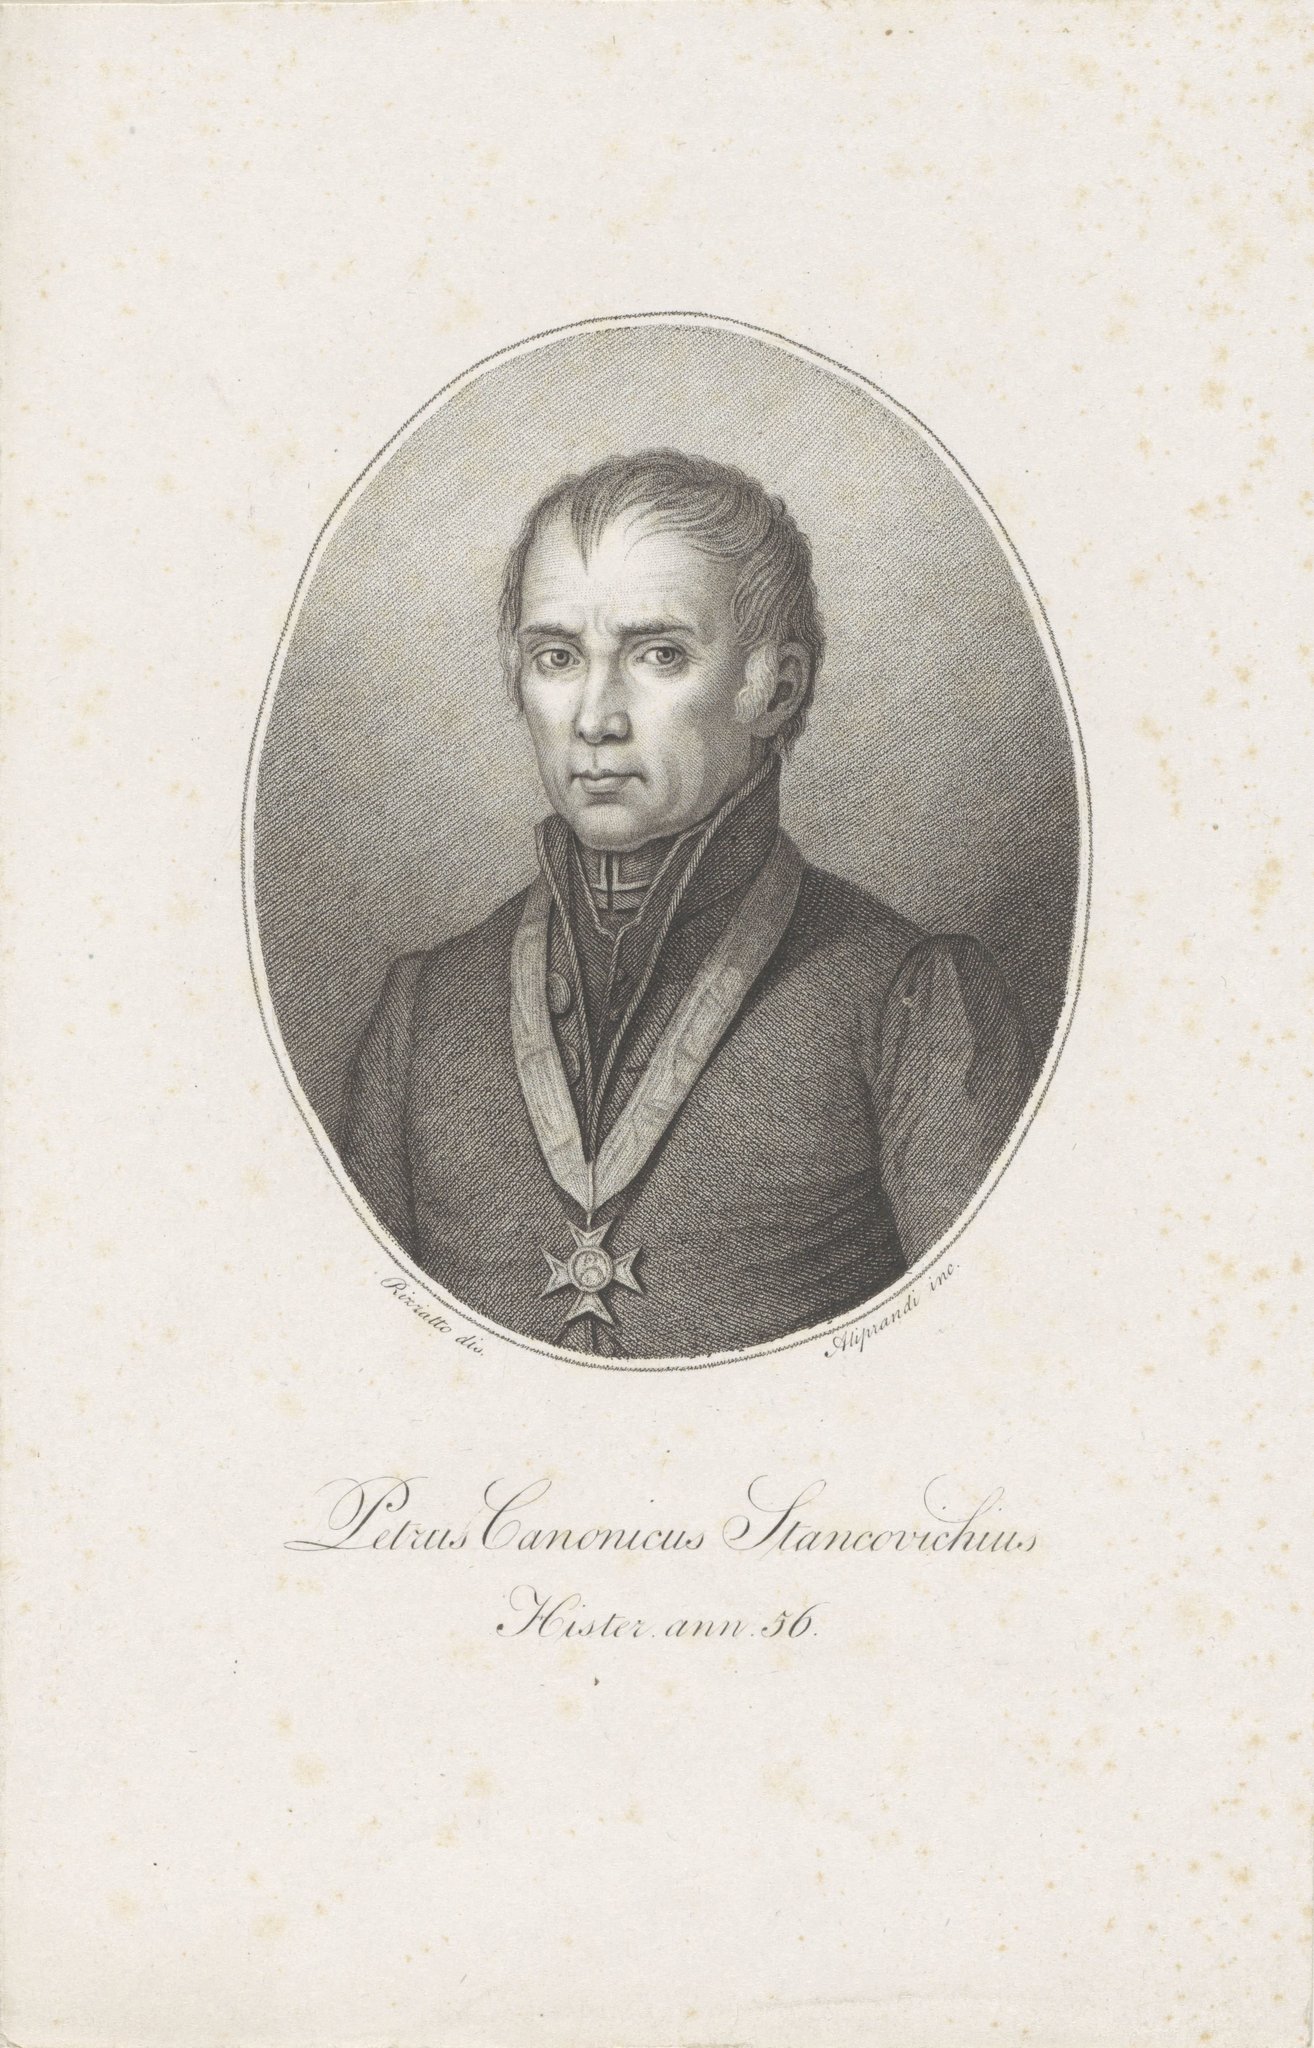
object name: print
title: Portret van Pietro Stancovich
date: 1775-1825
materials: paper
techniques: engraving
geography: italy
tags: historical persons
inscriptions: collector's mark: Lugt 2228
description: Portret van Pietro Stancovich in ovaal. Onder het portret zijn naam.